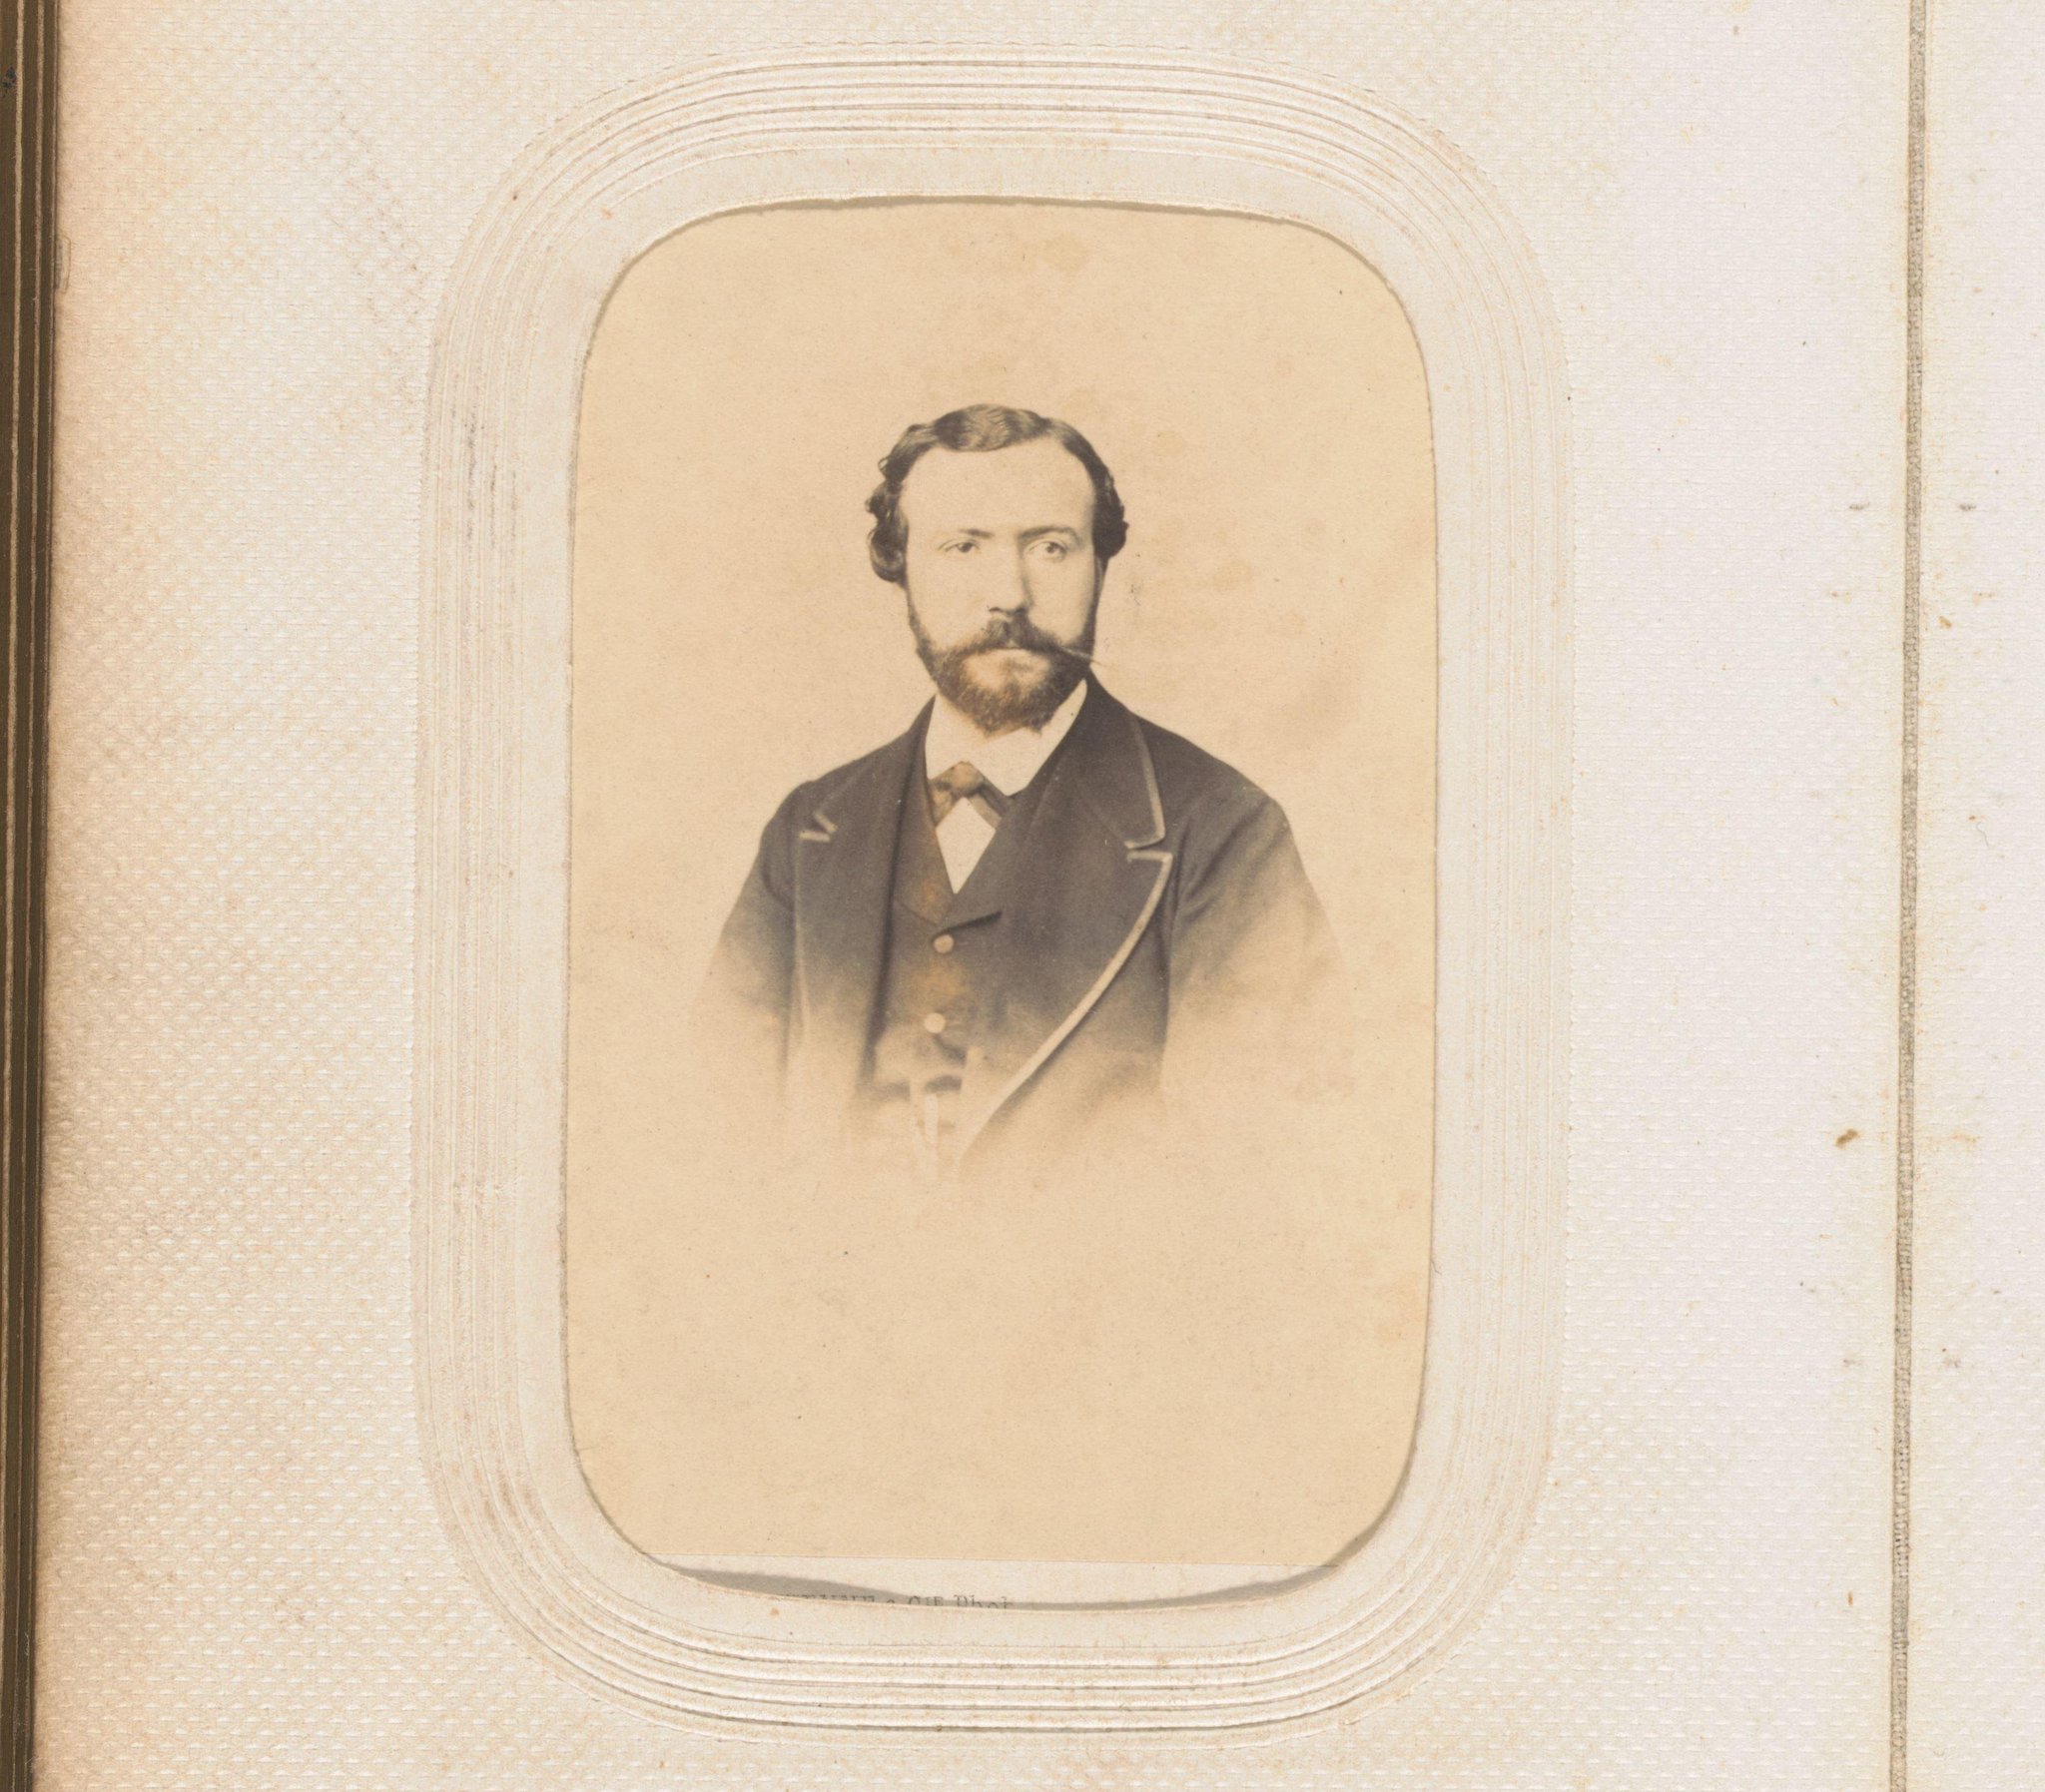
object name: photograph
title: Portret van een man met baard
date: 1855-1865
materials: cardboard, photographic support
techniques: albumen print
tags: adult man, historical persons, beard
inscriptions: inscription: ‘Rue de la Bourse 2, Paris’